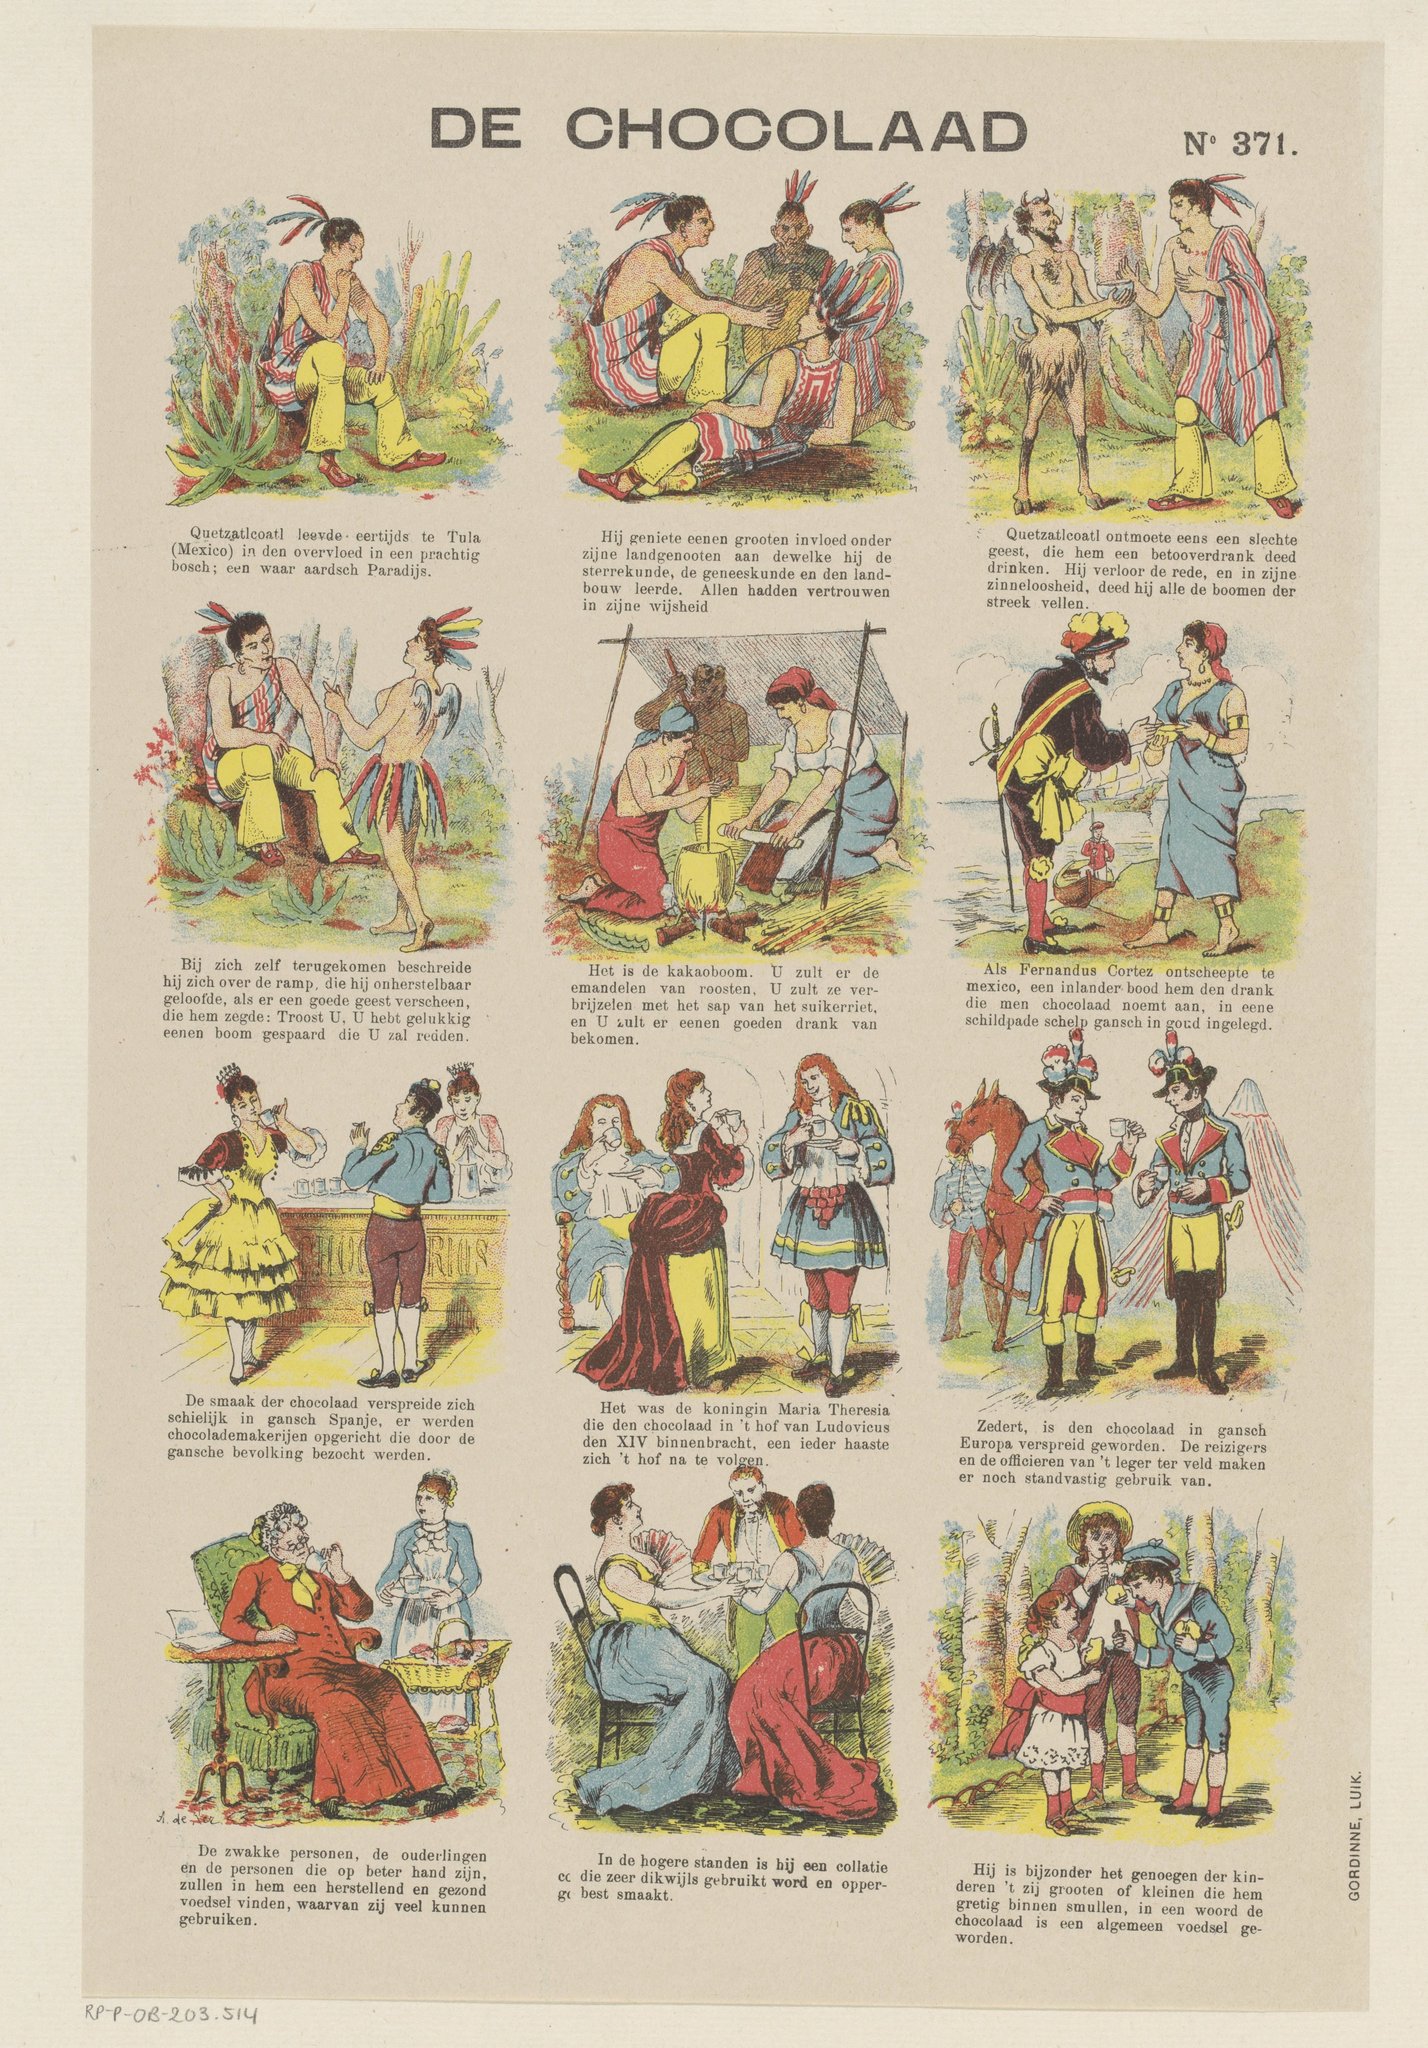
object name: popular print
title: De chocolaad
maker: Anonymous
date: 1894-1959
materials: paper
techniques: lithograph, letterpress printing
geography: liège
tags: chocolate, cocoa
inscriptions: collector's mark: Lugt 2760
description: Blad met 12 voorstellingen over de ontdekking van chocolademelk in Mexico, en de verspreiding van chocolademelk in Europa. Onder elke afbeelding een onderschrift. Genummerd rechtsboven: No 371.